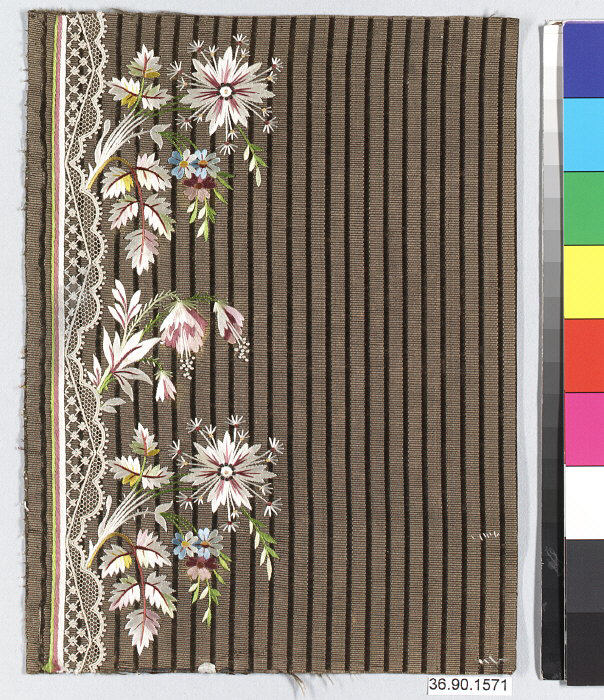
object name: sample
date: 1801-1833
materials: silk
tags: flowers